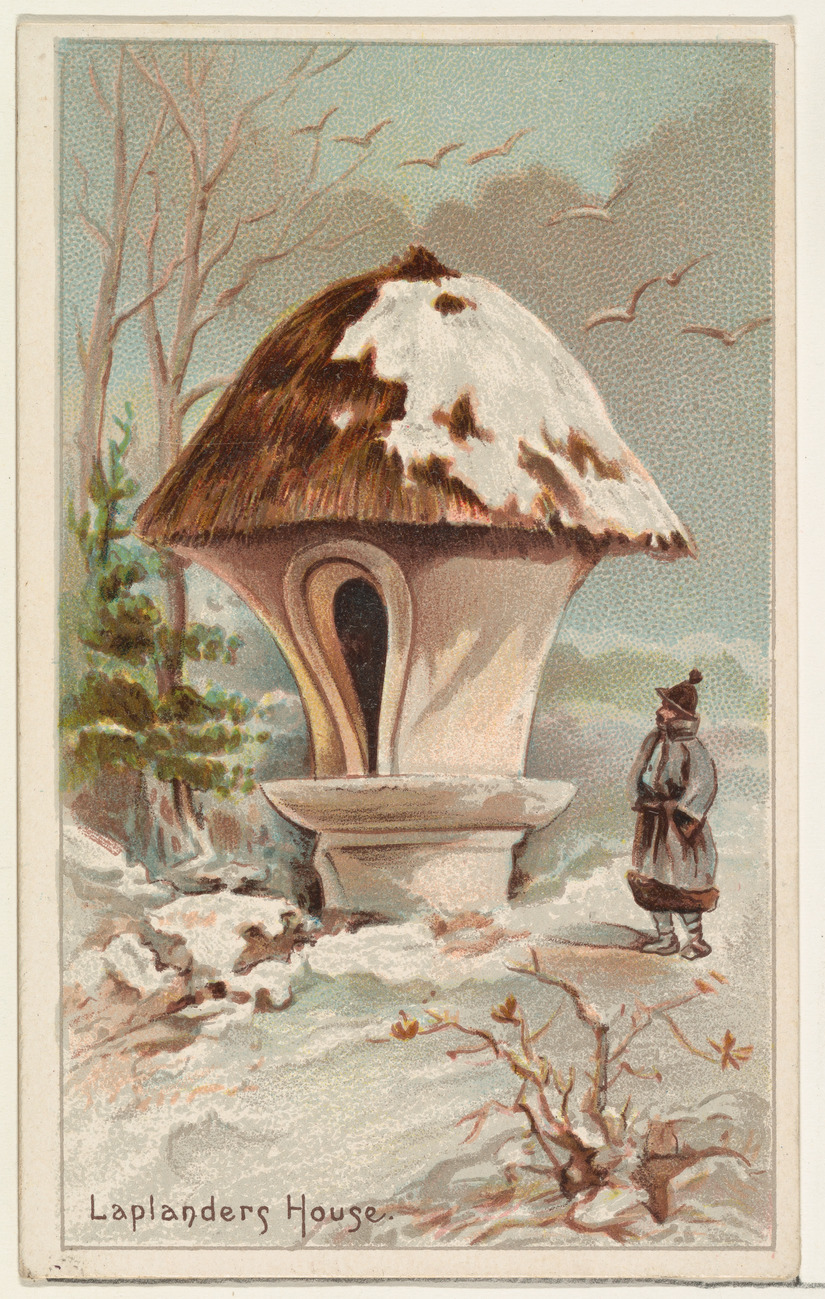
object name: print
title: Laplanders House, from the Habitations of Man series (N113) issued by W. Duke, Sons & Co. to promote Honest Long Cut Smoking and Chewing Tobacco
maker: the giles company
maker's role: artist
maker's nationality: american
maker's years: 1800-1900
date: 1890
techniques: color lithograph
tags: houses,men